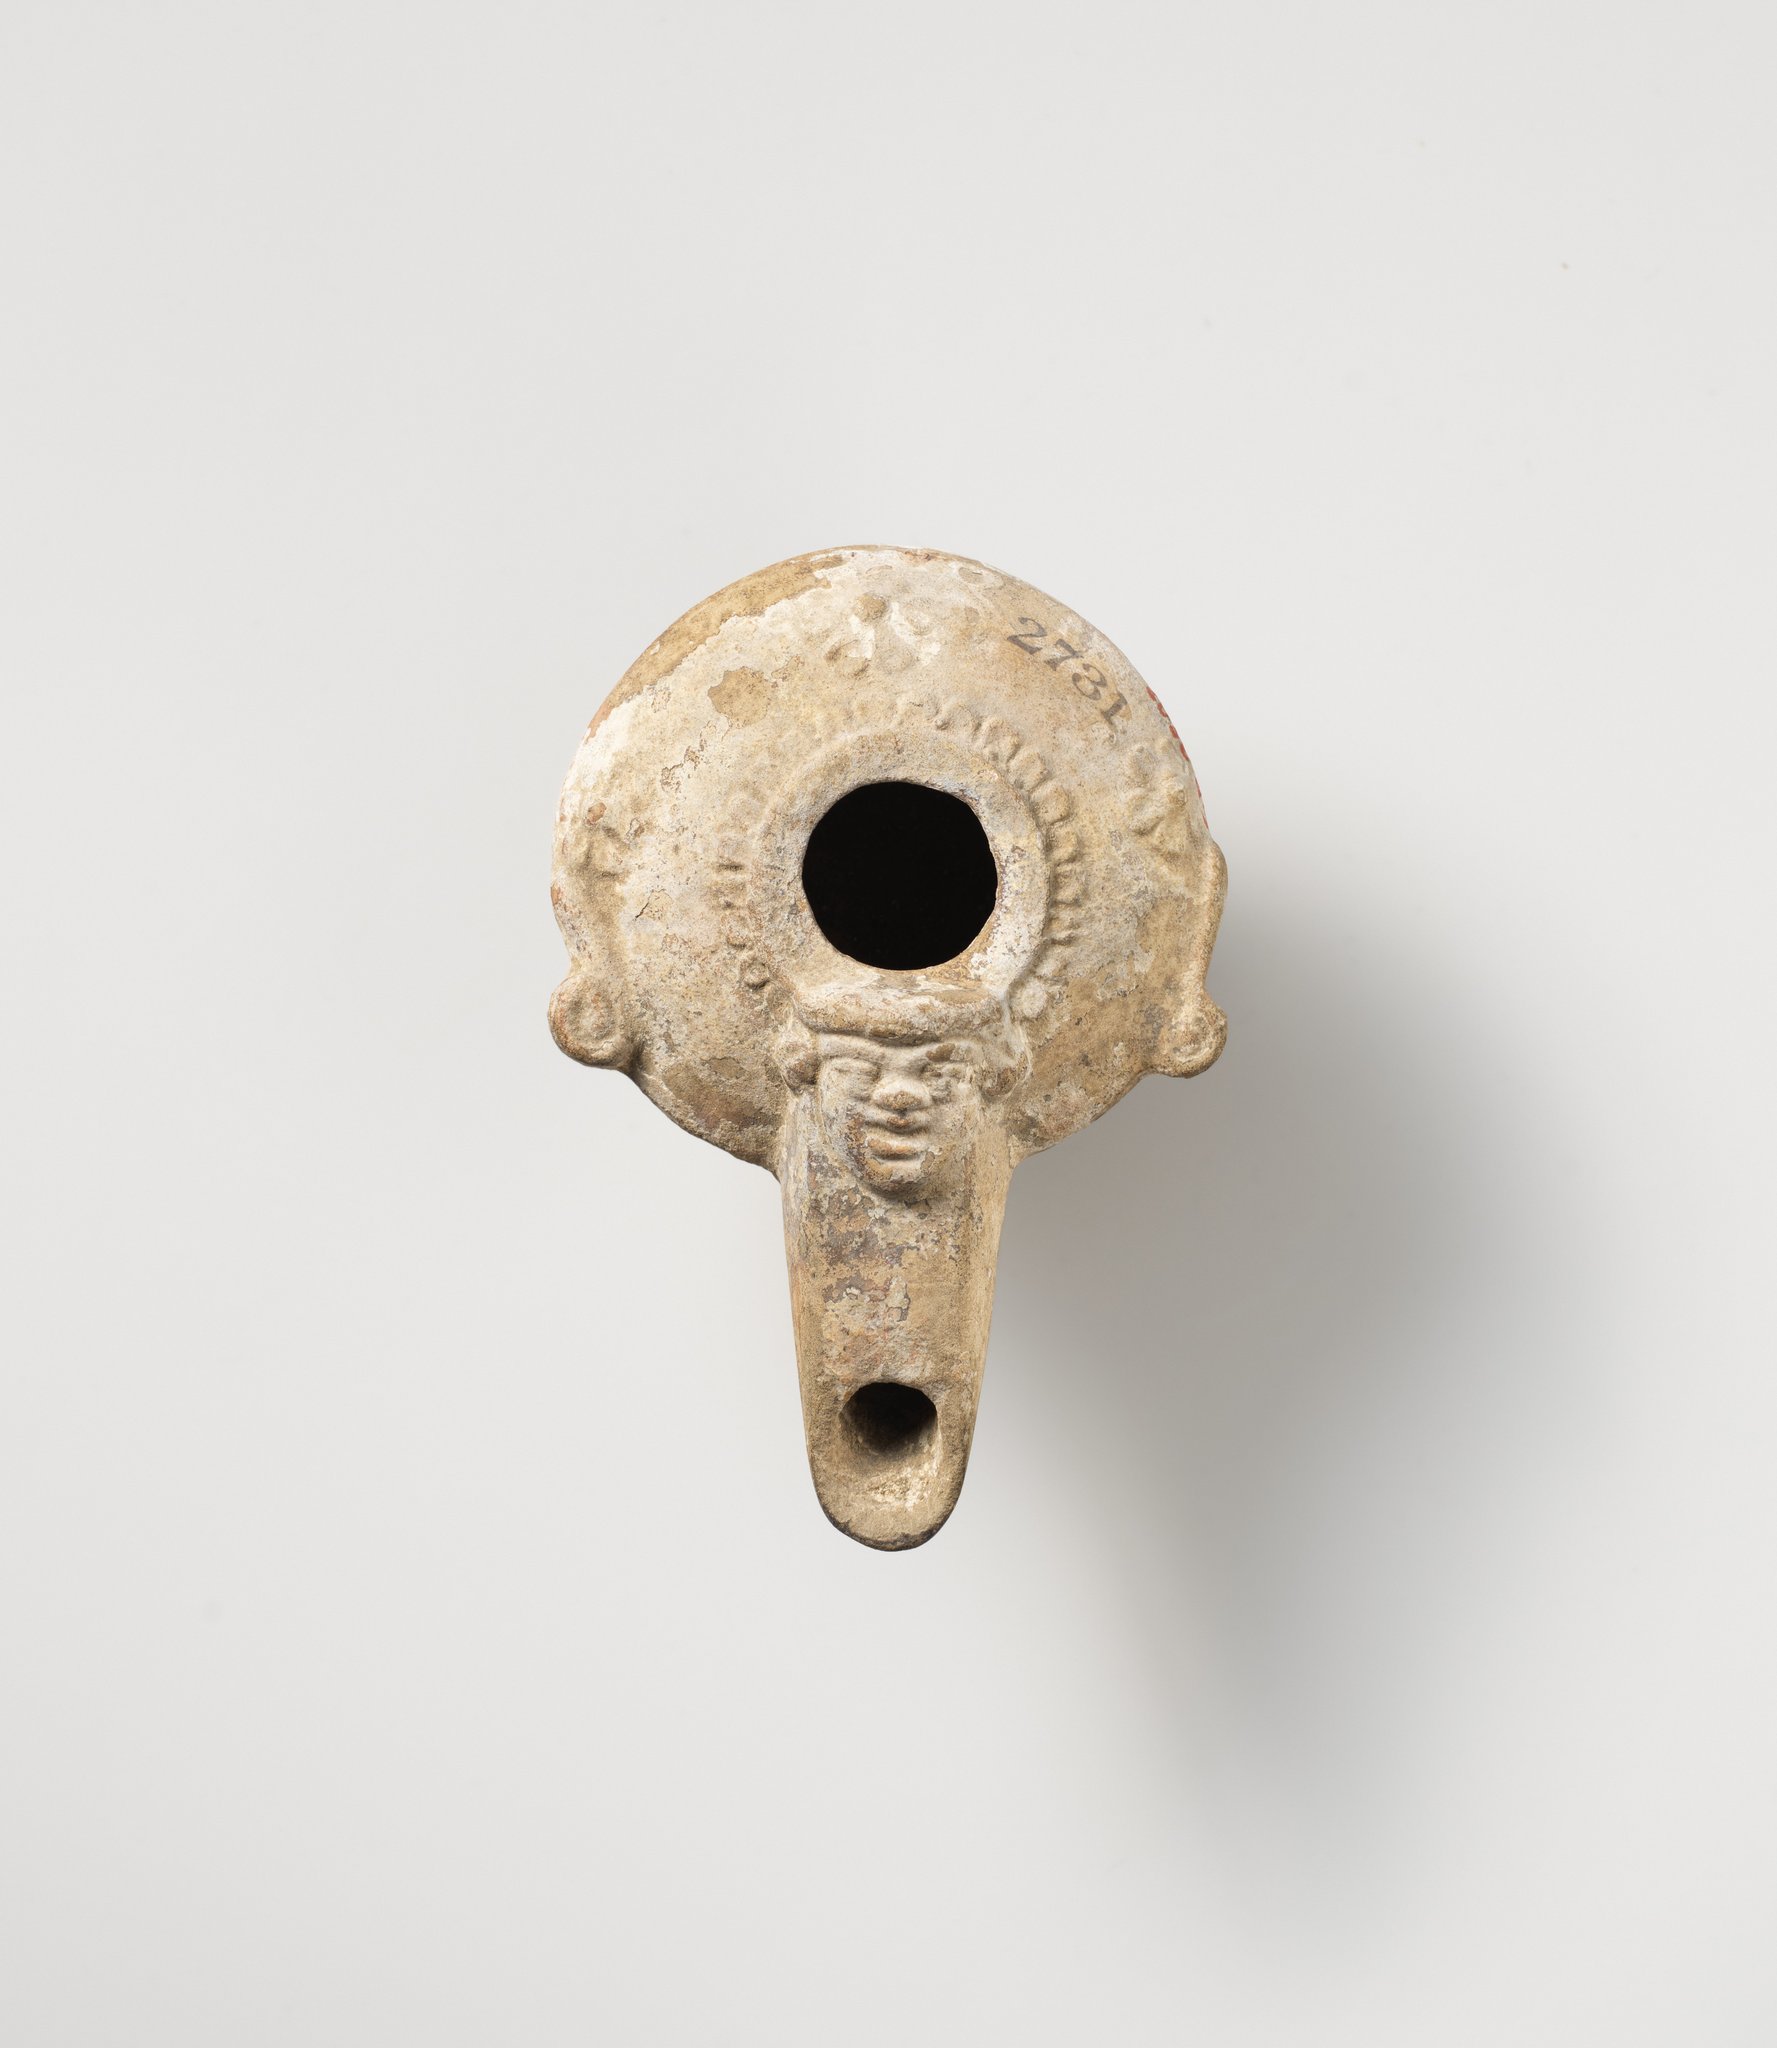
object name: lamp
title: Terracotta oil lamp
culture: greek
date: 7000 BCE-330 CE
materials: terracotta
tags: satyrs